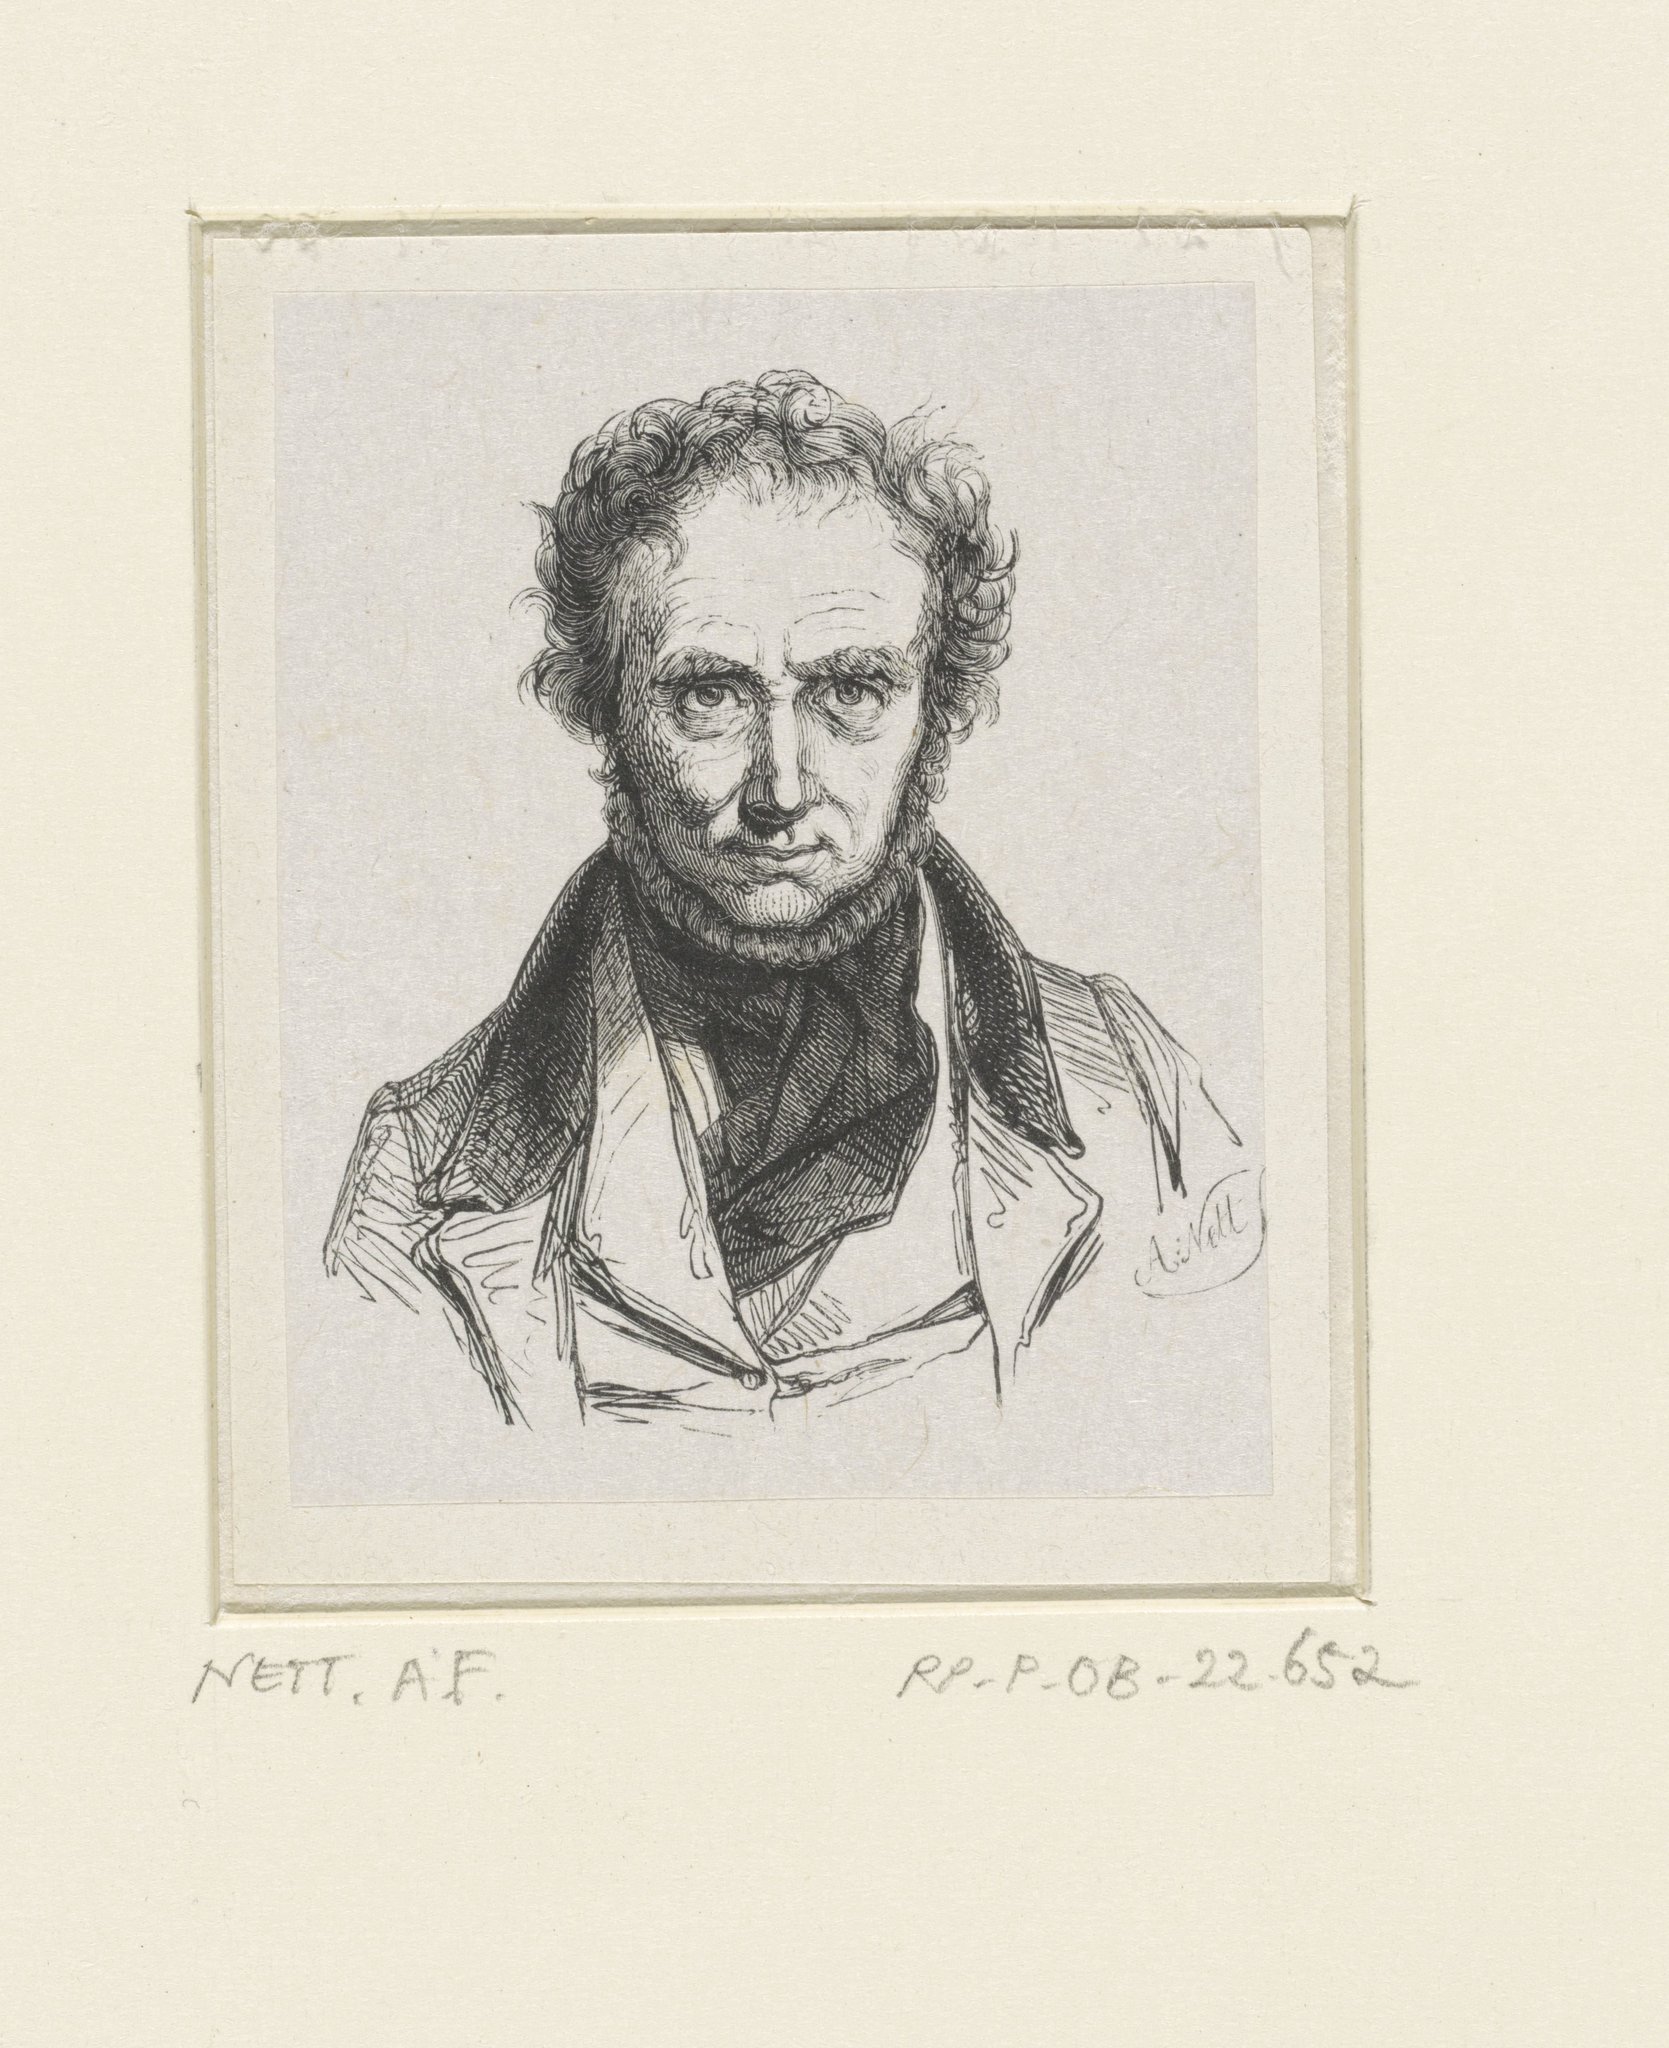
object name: print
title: Portret van I.J. van Regemorter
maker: adolphe frédéric nett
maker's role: print maker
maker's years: 1822-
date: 1832-1900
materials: paper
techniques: engraving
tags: antwerp, painter, conservator, ignatius josephus van regemorter, historical persons, portrait, self-portrait of artist